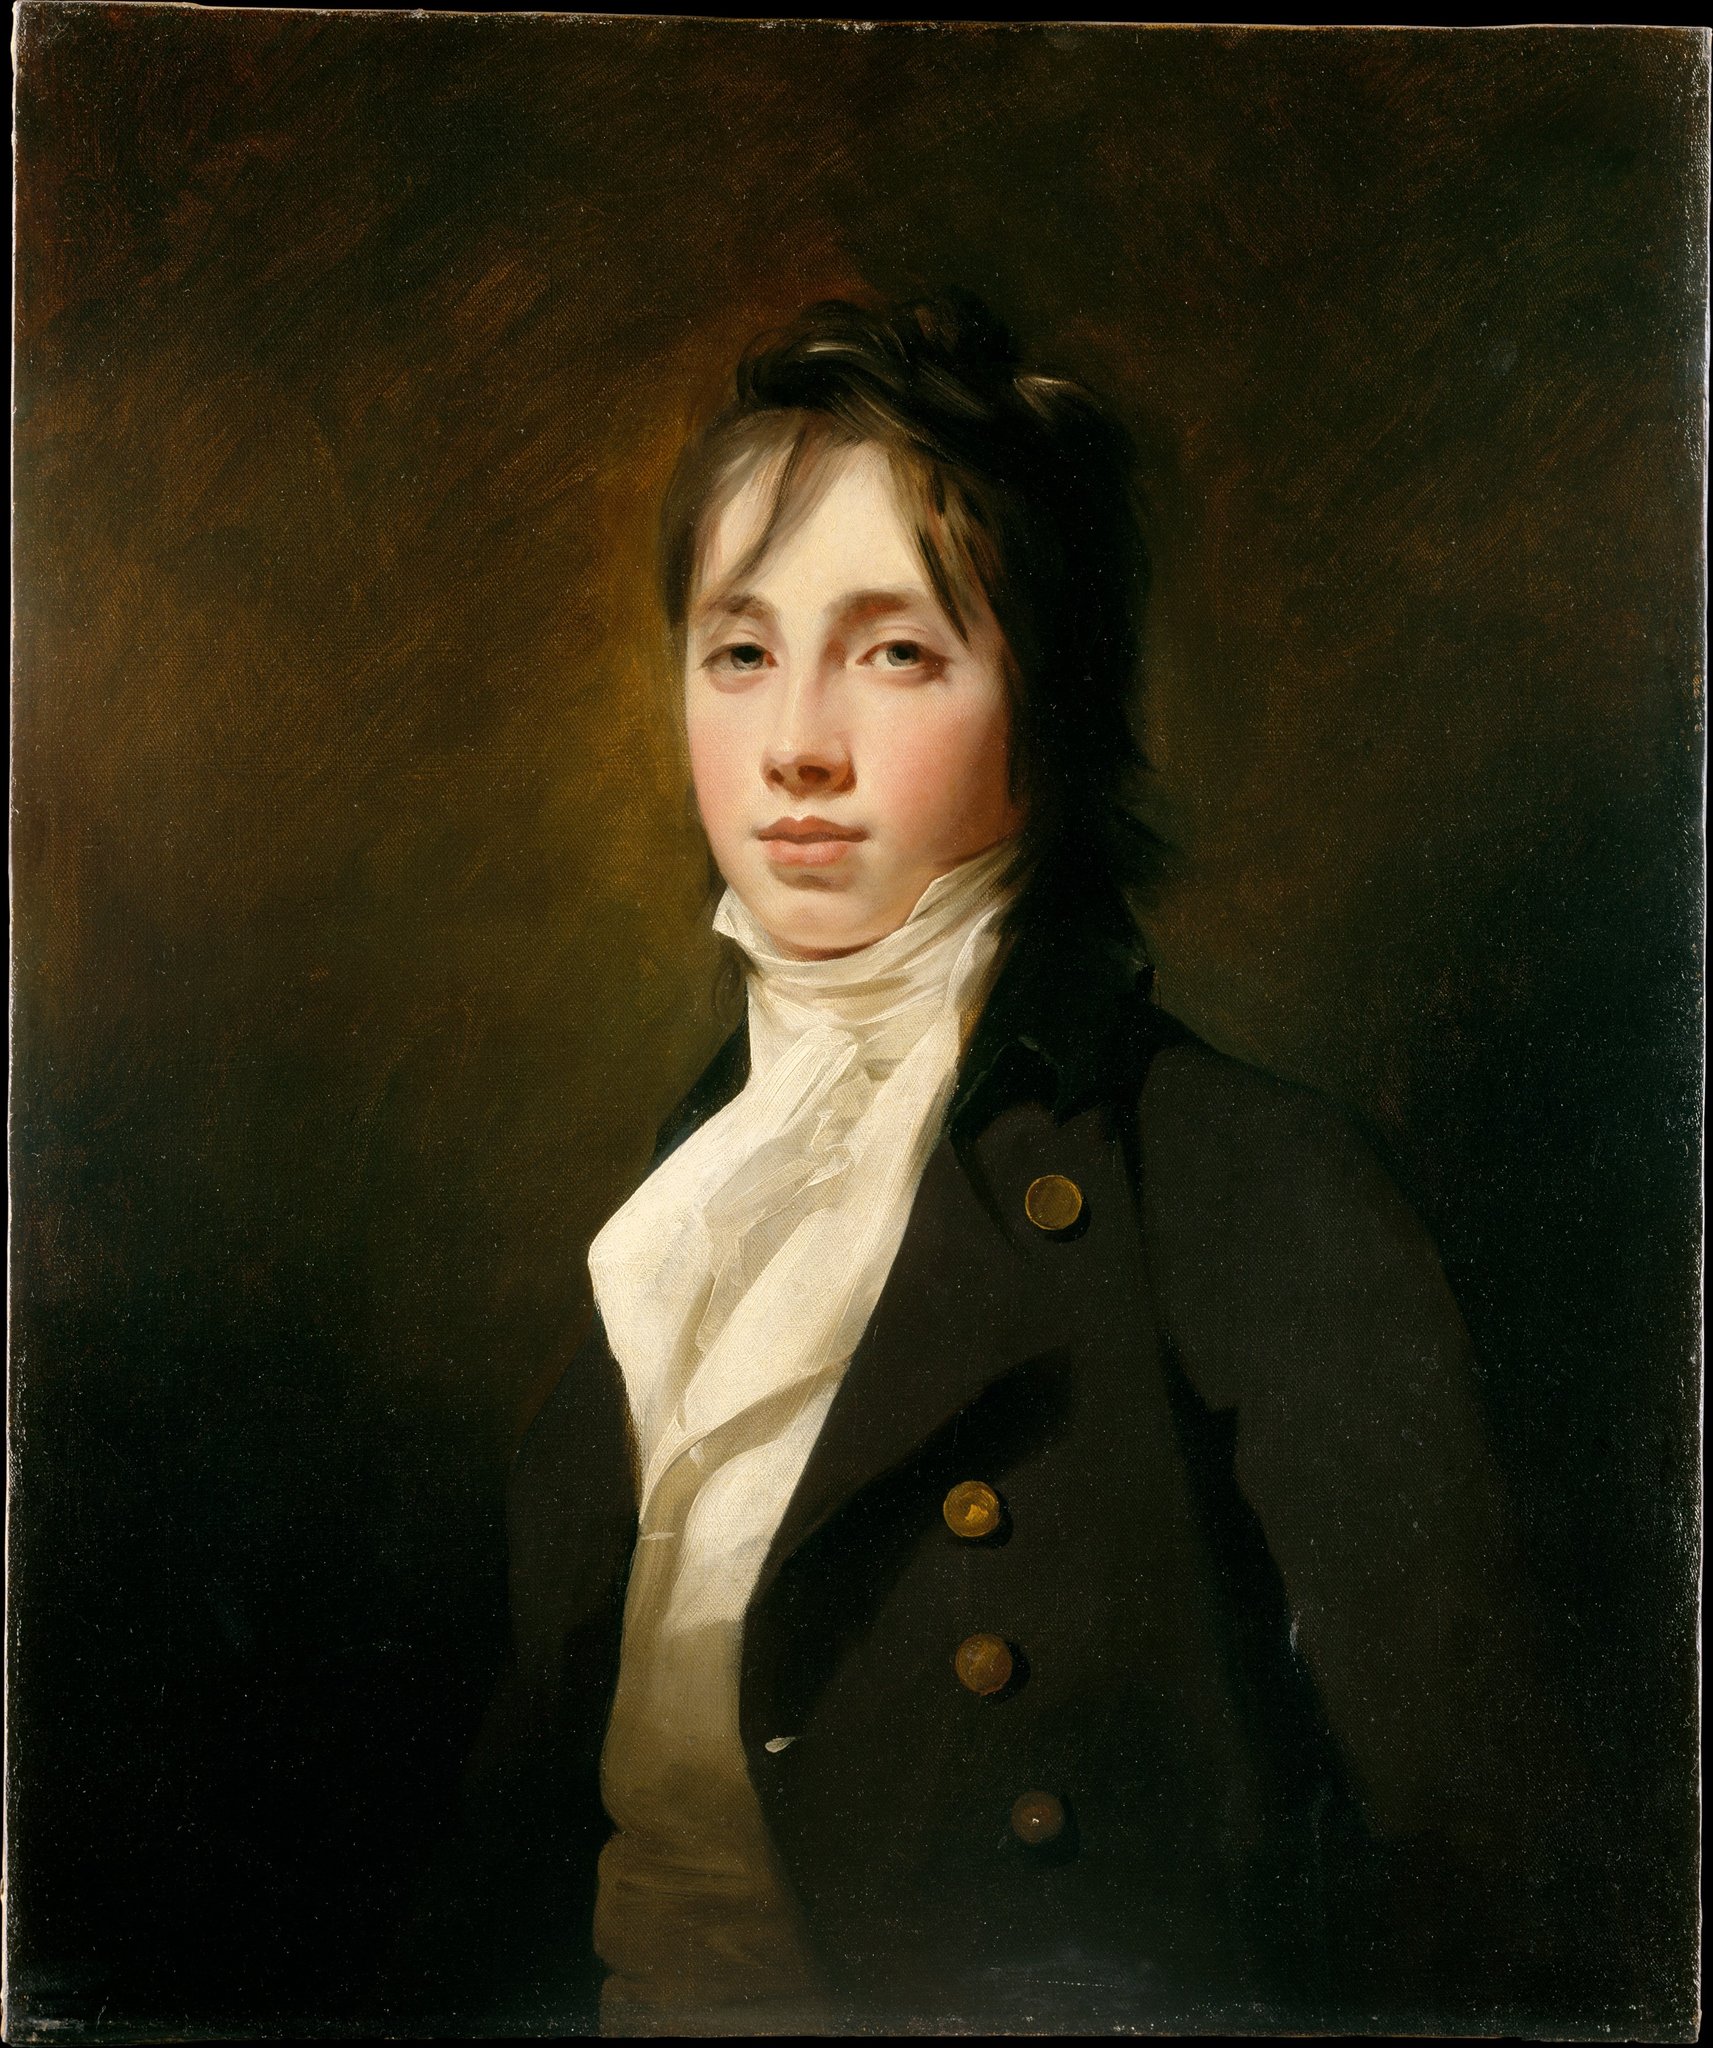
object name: painting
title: William Fraser of Reelig (1784–1835)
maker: sir henry raeburn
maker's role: artist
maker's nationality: british, scottish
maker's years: 1756-1923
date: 1801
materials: canvas, oil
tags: men,portraits